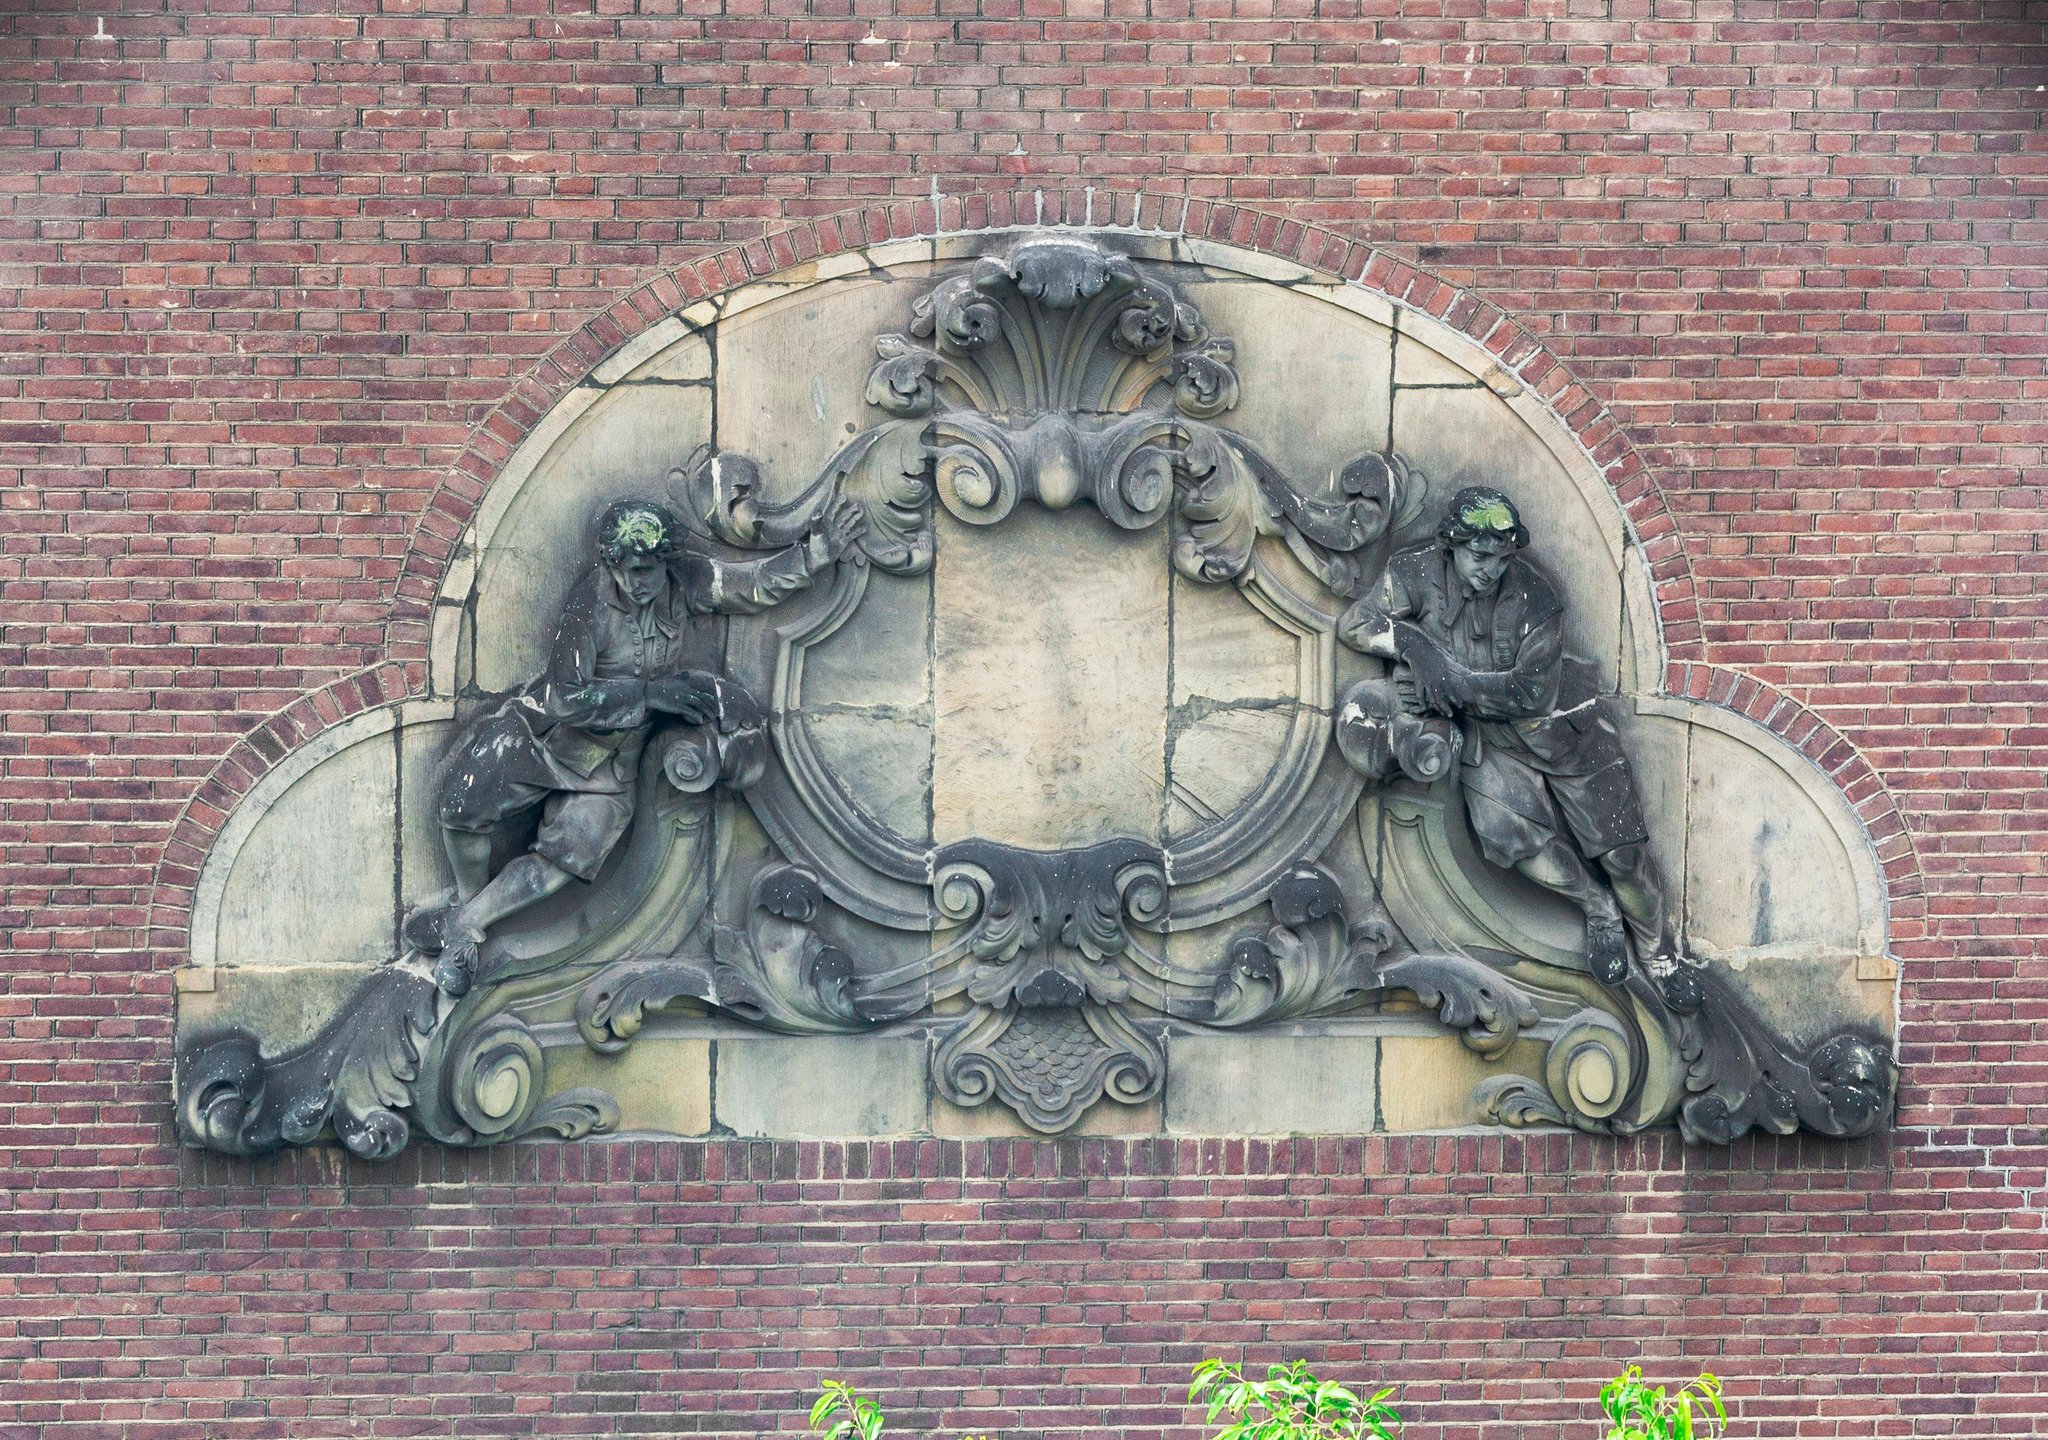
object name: geveltop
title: Gable Stone with a Cartouche Flanked by Two Orphan Boys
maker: ignatius van logteren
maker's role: sculptor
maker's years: 1685-1732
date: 1725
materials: stone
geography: amsterdam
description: Tegen een van boven drielobbig timpaan bevindt zich in het midden een cartouche met links en rechts een zijdelings afhangende gebroken S-voluut. Op elk dezer staat half leunend tegen de cartouche een levensgrote weesjongen: de rechter laat de over elkaar liggende handen rusten op een bal; de linker, meer in zithouding, houdt de opgestoken linkerhand en -arm in de richting van de cartouche (wellicht voor een geschilderd opschrift) en laat de rechter eveneens op een bal rusten. Uit het lijstwerk van cartouche en S-voluten in Lodewijk XIV-stijl ontspringen acanthusbladeren, die boven de cartouche een palmet vormen. De weesjongens zijn gekleed in eigentijds kostuum, bestaande uit een hemd, een jas en halsdoek, een korte broek, kousen en schoenen met strik.